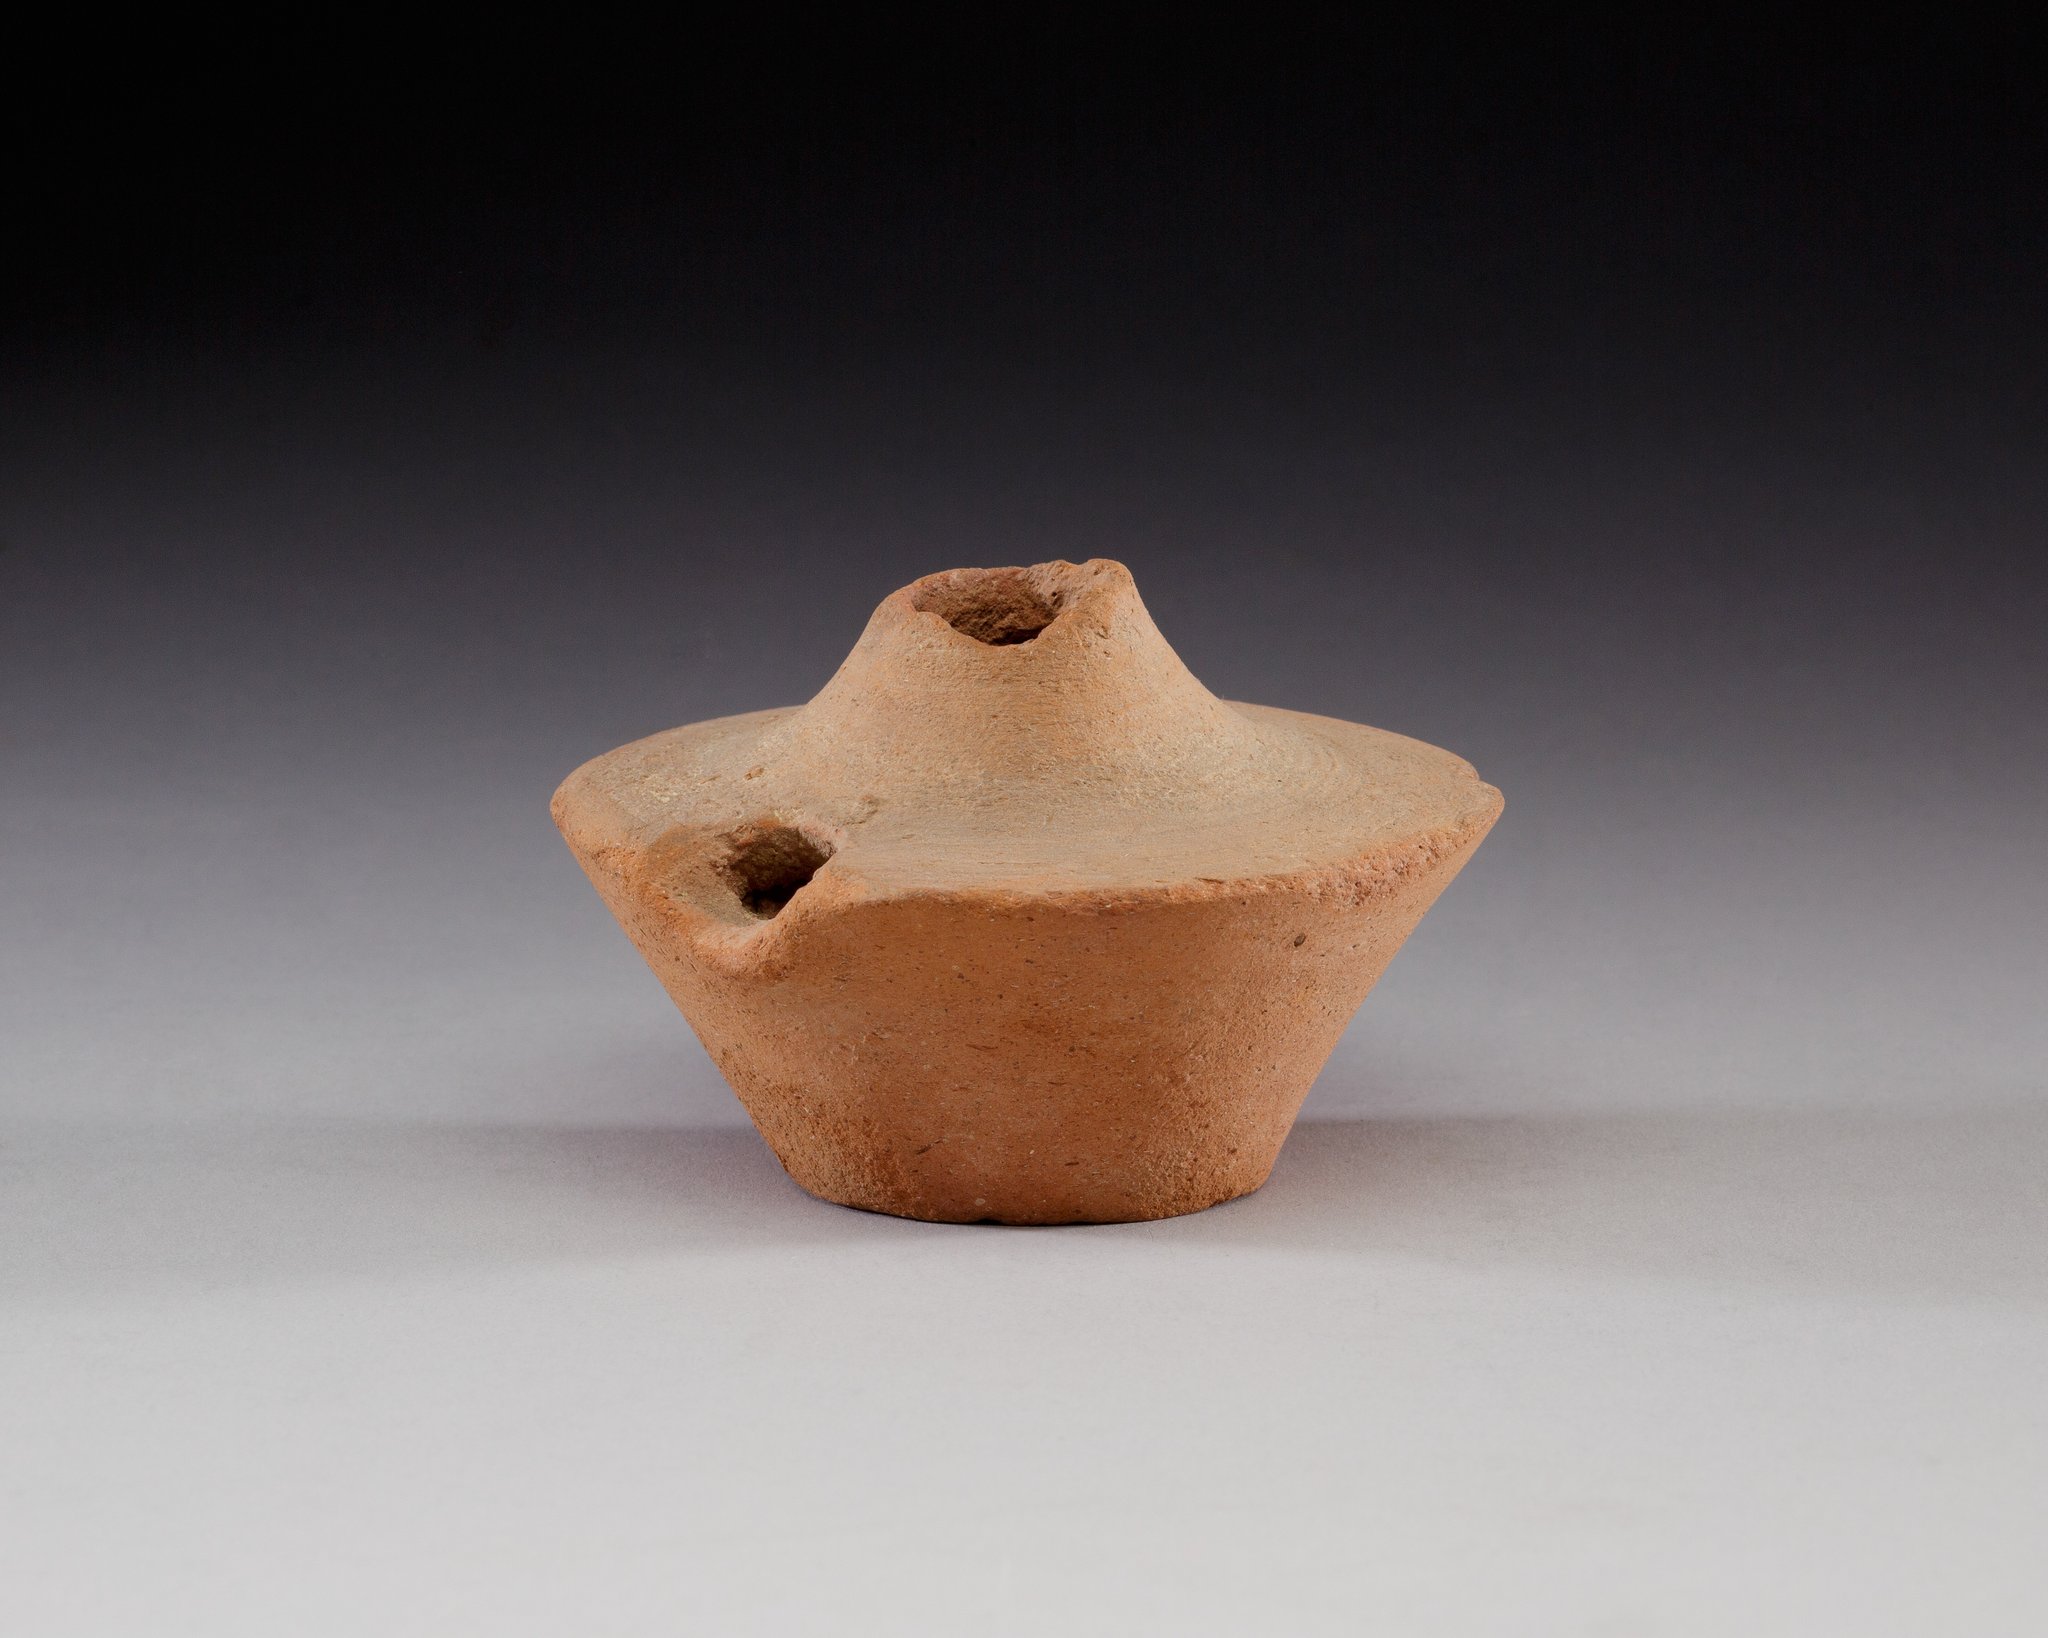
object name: lamp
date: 1850-1640 BCE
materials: pottery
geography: egypt